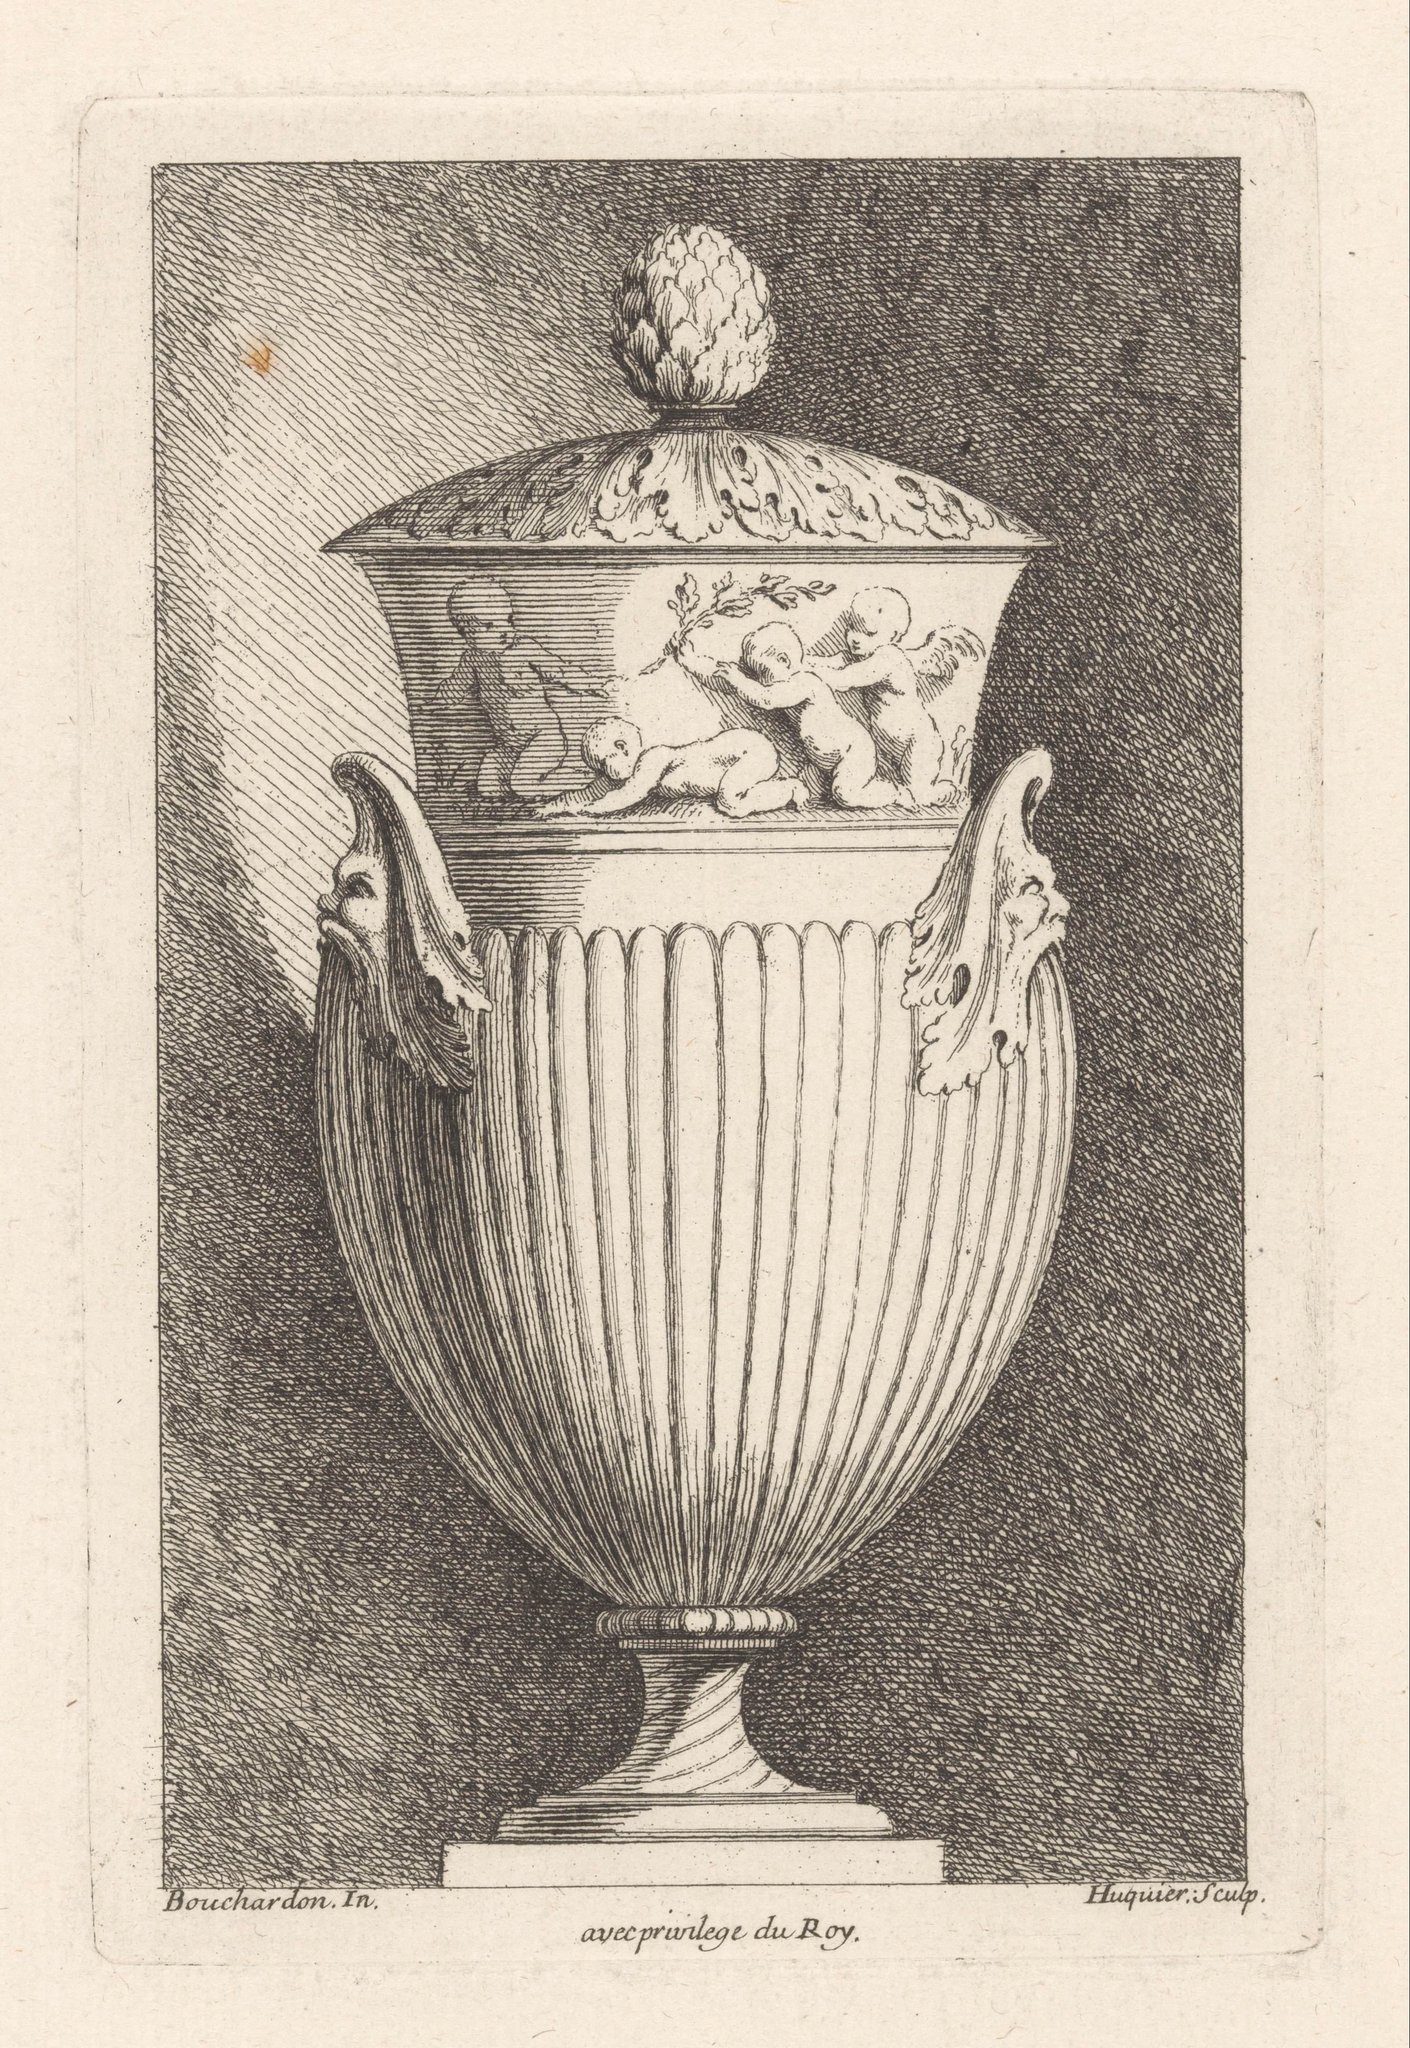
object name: ornament print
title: Vaas met putti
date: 1729-1737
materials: paper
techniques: etching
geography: paris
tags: fruits: pineapple, vase ~ ornament, mask, mascaron ~ ornament, cupids: 'amores', 'amoretti', 'putti'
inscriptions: collector's mark: Lugt 2228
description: Een vaas met twee maskers, vier putti en een dennenappel.